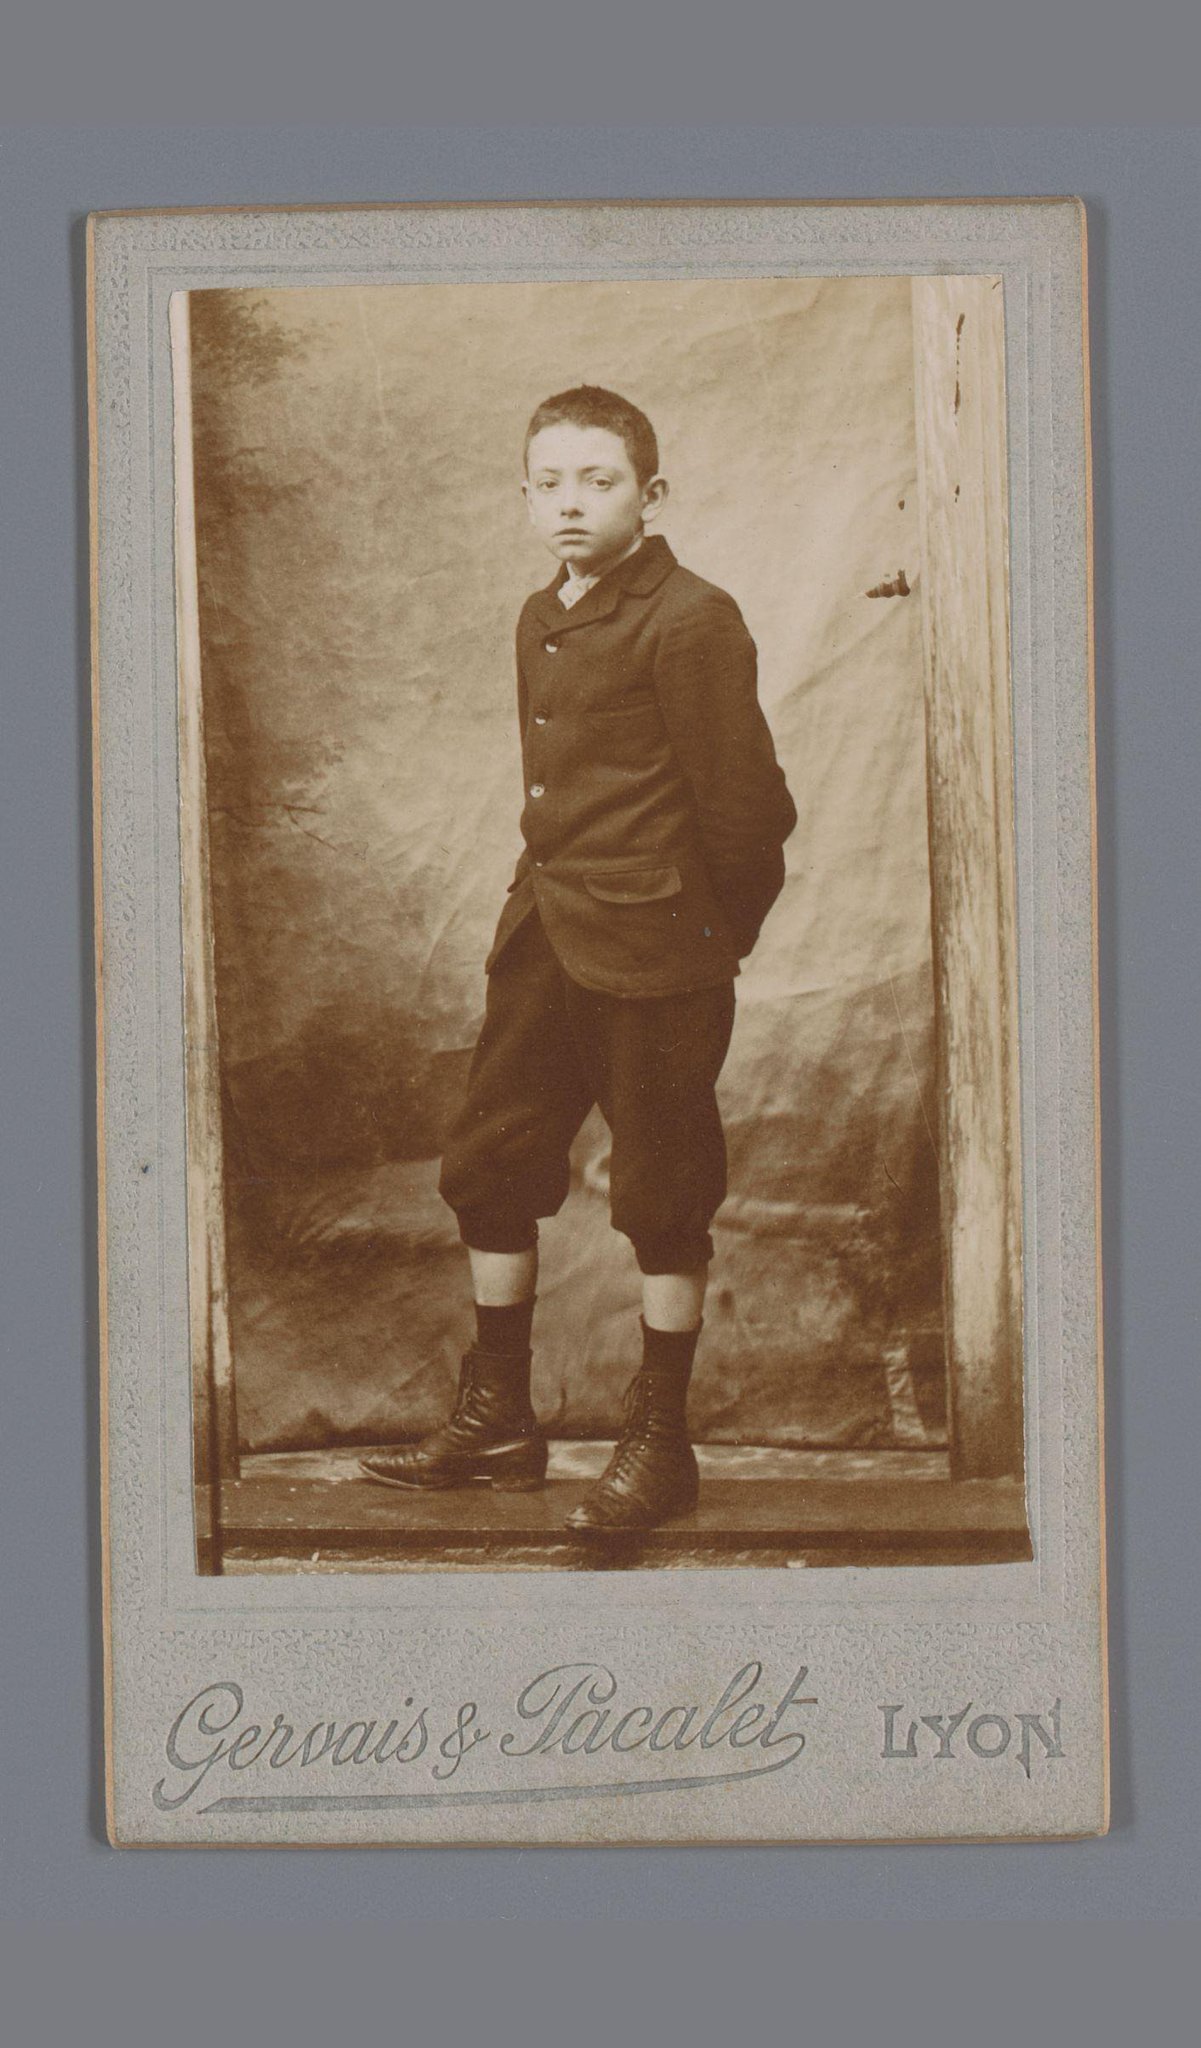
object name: photograph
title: Portret van een onbekende jongen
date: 1900-1914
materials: paper, cardboard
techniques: gelatin silver print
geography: lyon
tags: boy (child between toddler and youth), anonymous historical person portrayed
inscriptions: inscription: ‘Reproductions/ Agrandissements/ Traveaux Photographiques/ Les Clichés sont conservés No........’